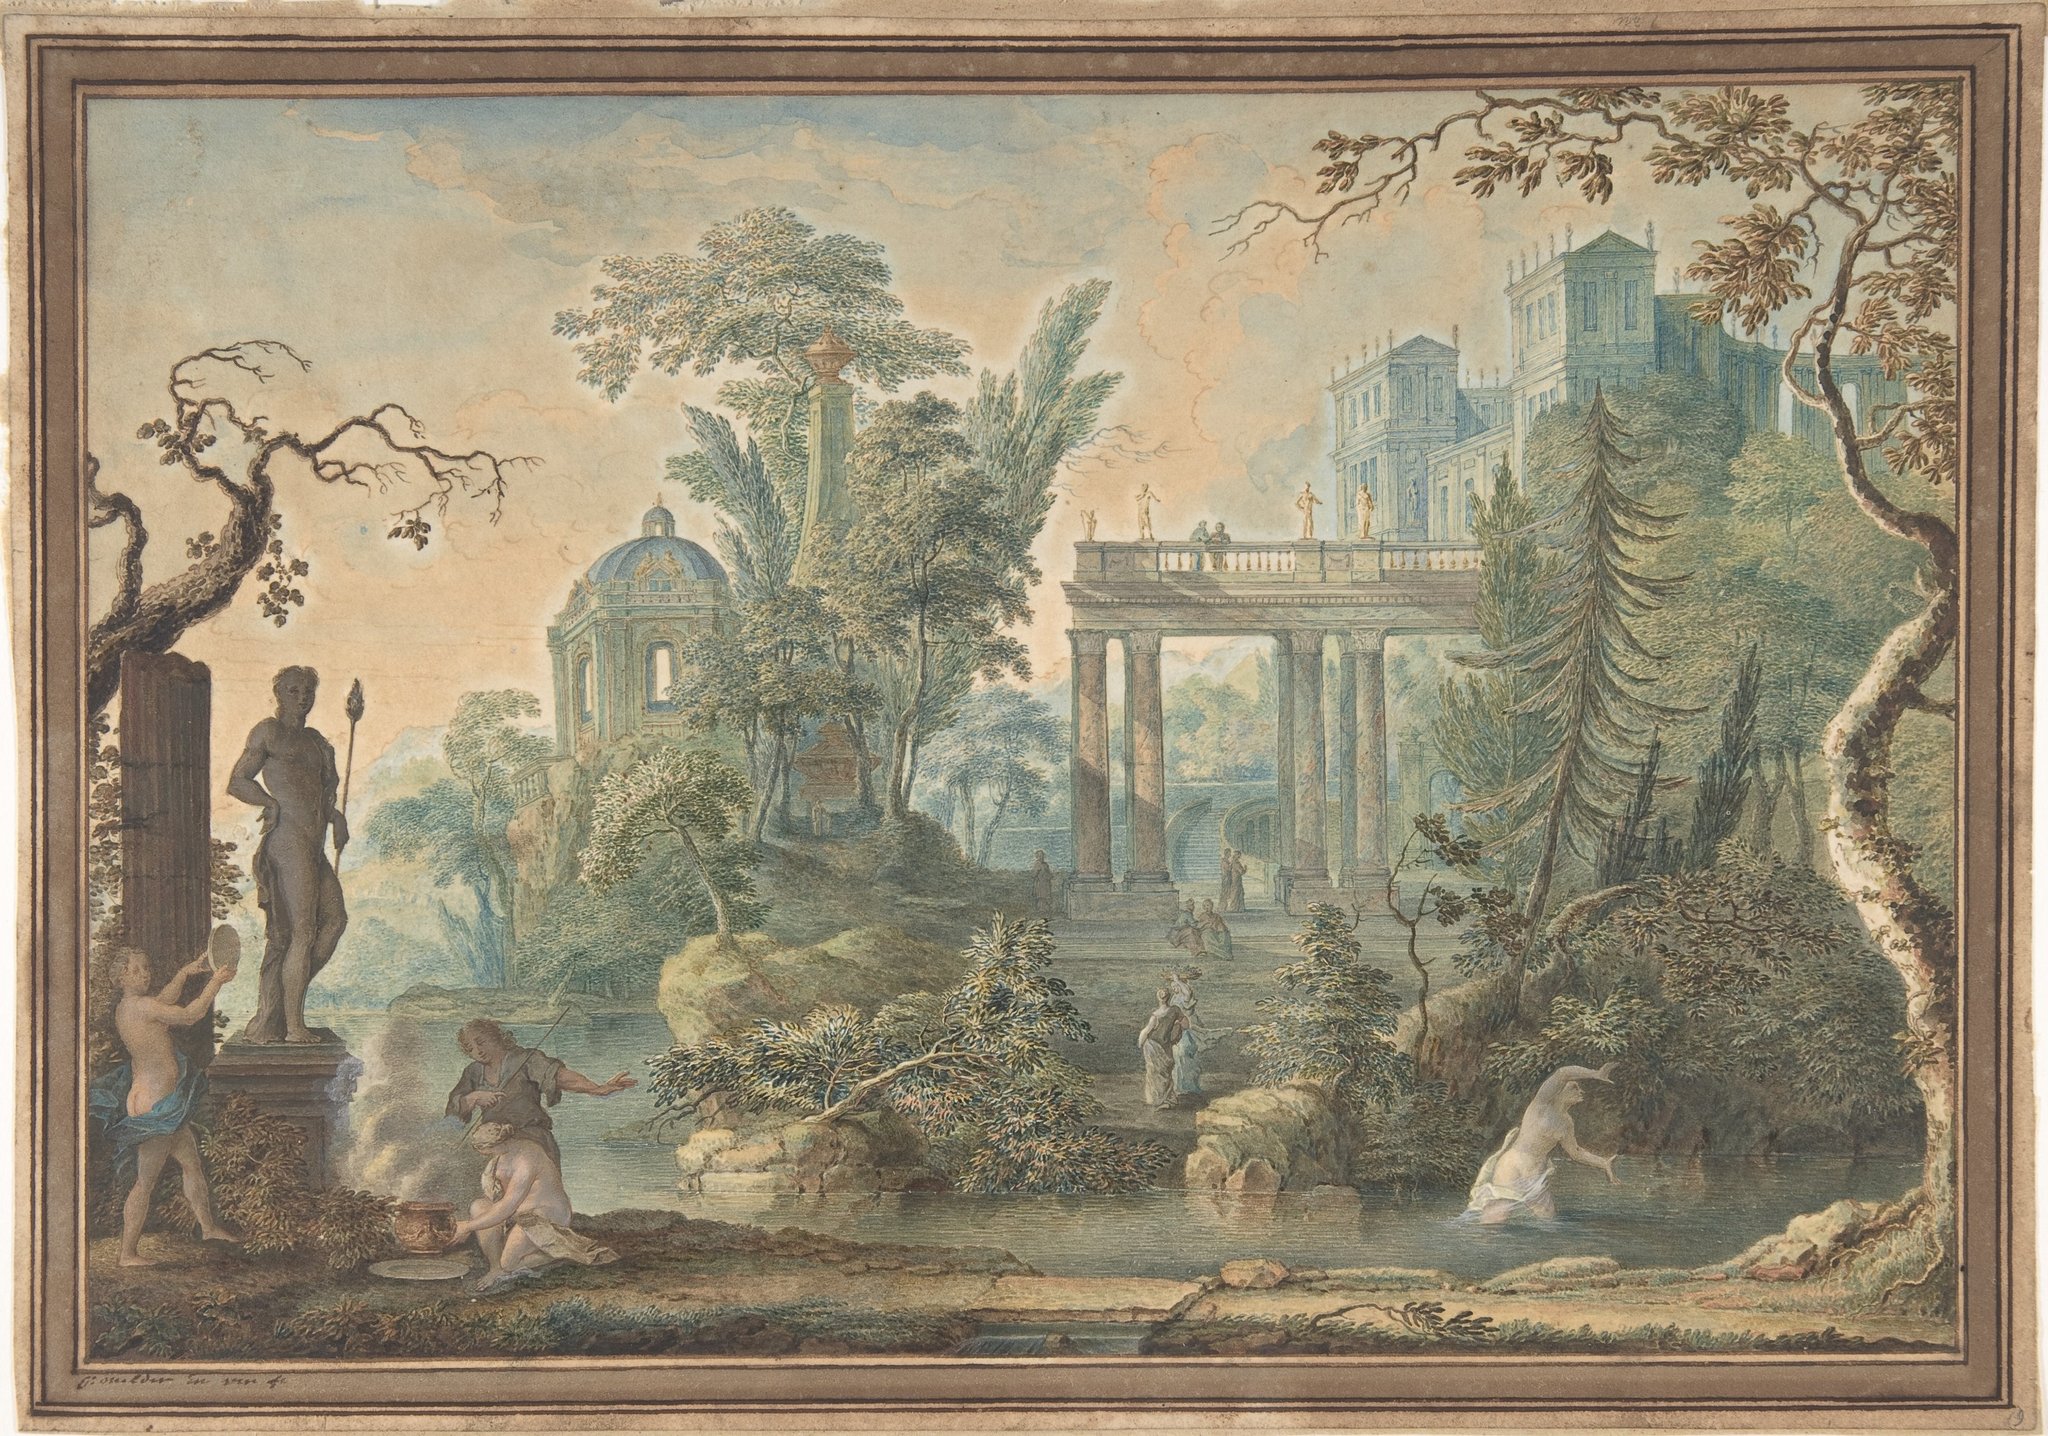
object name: drawing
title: Arcadian Landscape with several Figures and a Statue of Apollo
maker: gerard melder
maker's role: artist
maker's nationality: dutch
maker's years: 1693-1754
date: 1701-1800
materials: gouache, watercolor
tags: buildings,women,female nudes,apollo,trees